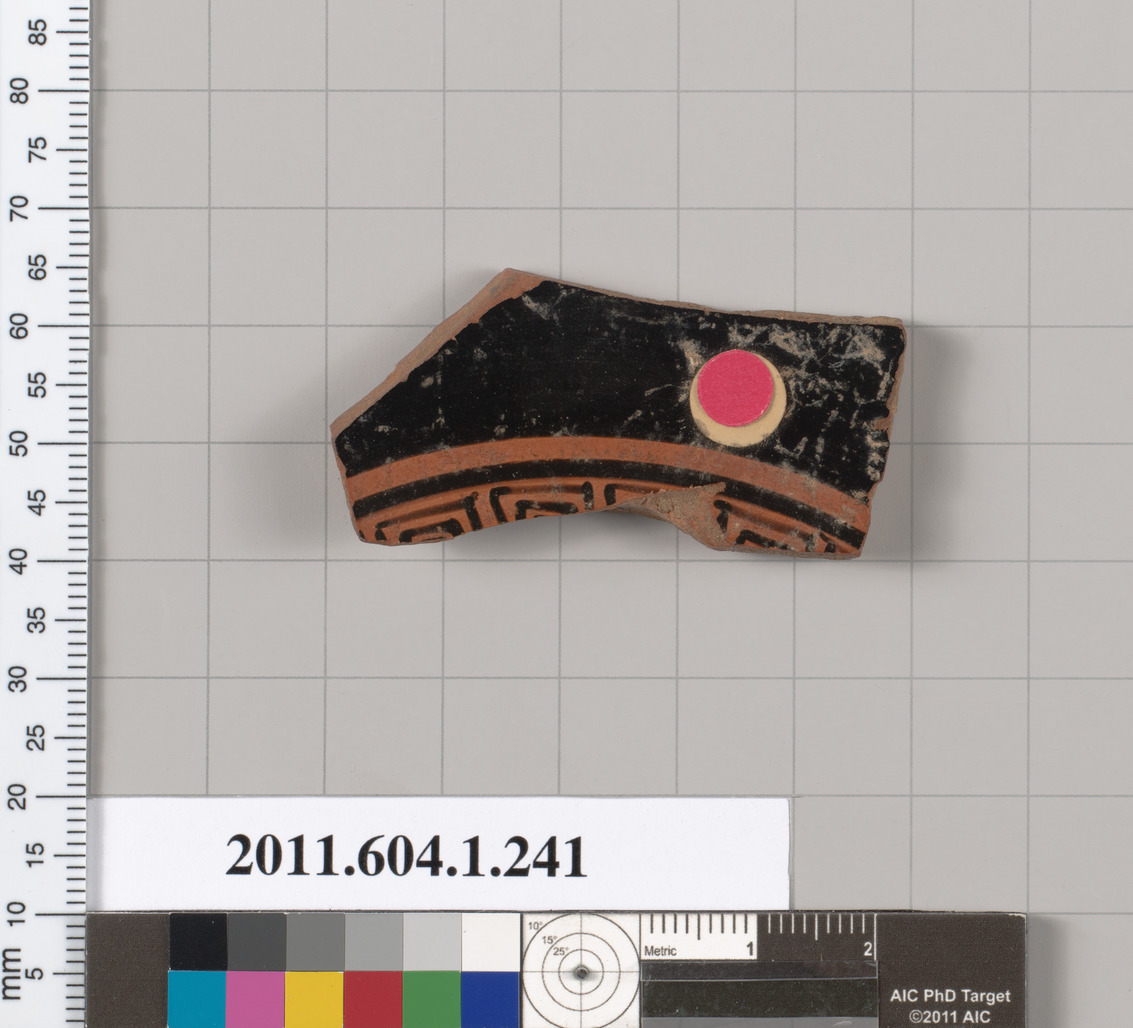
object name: kylix fragment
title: Terracotta fragment of a kylix (drinking cup)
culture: greek, attic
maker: angular painter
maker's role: artist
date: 475-451 BCE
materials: terracotta